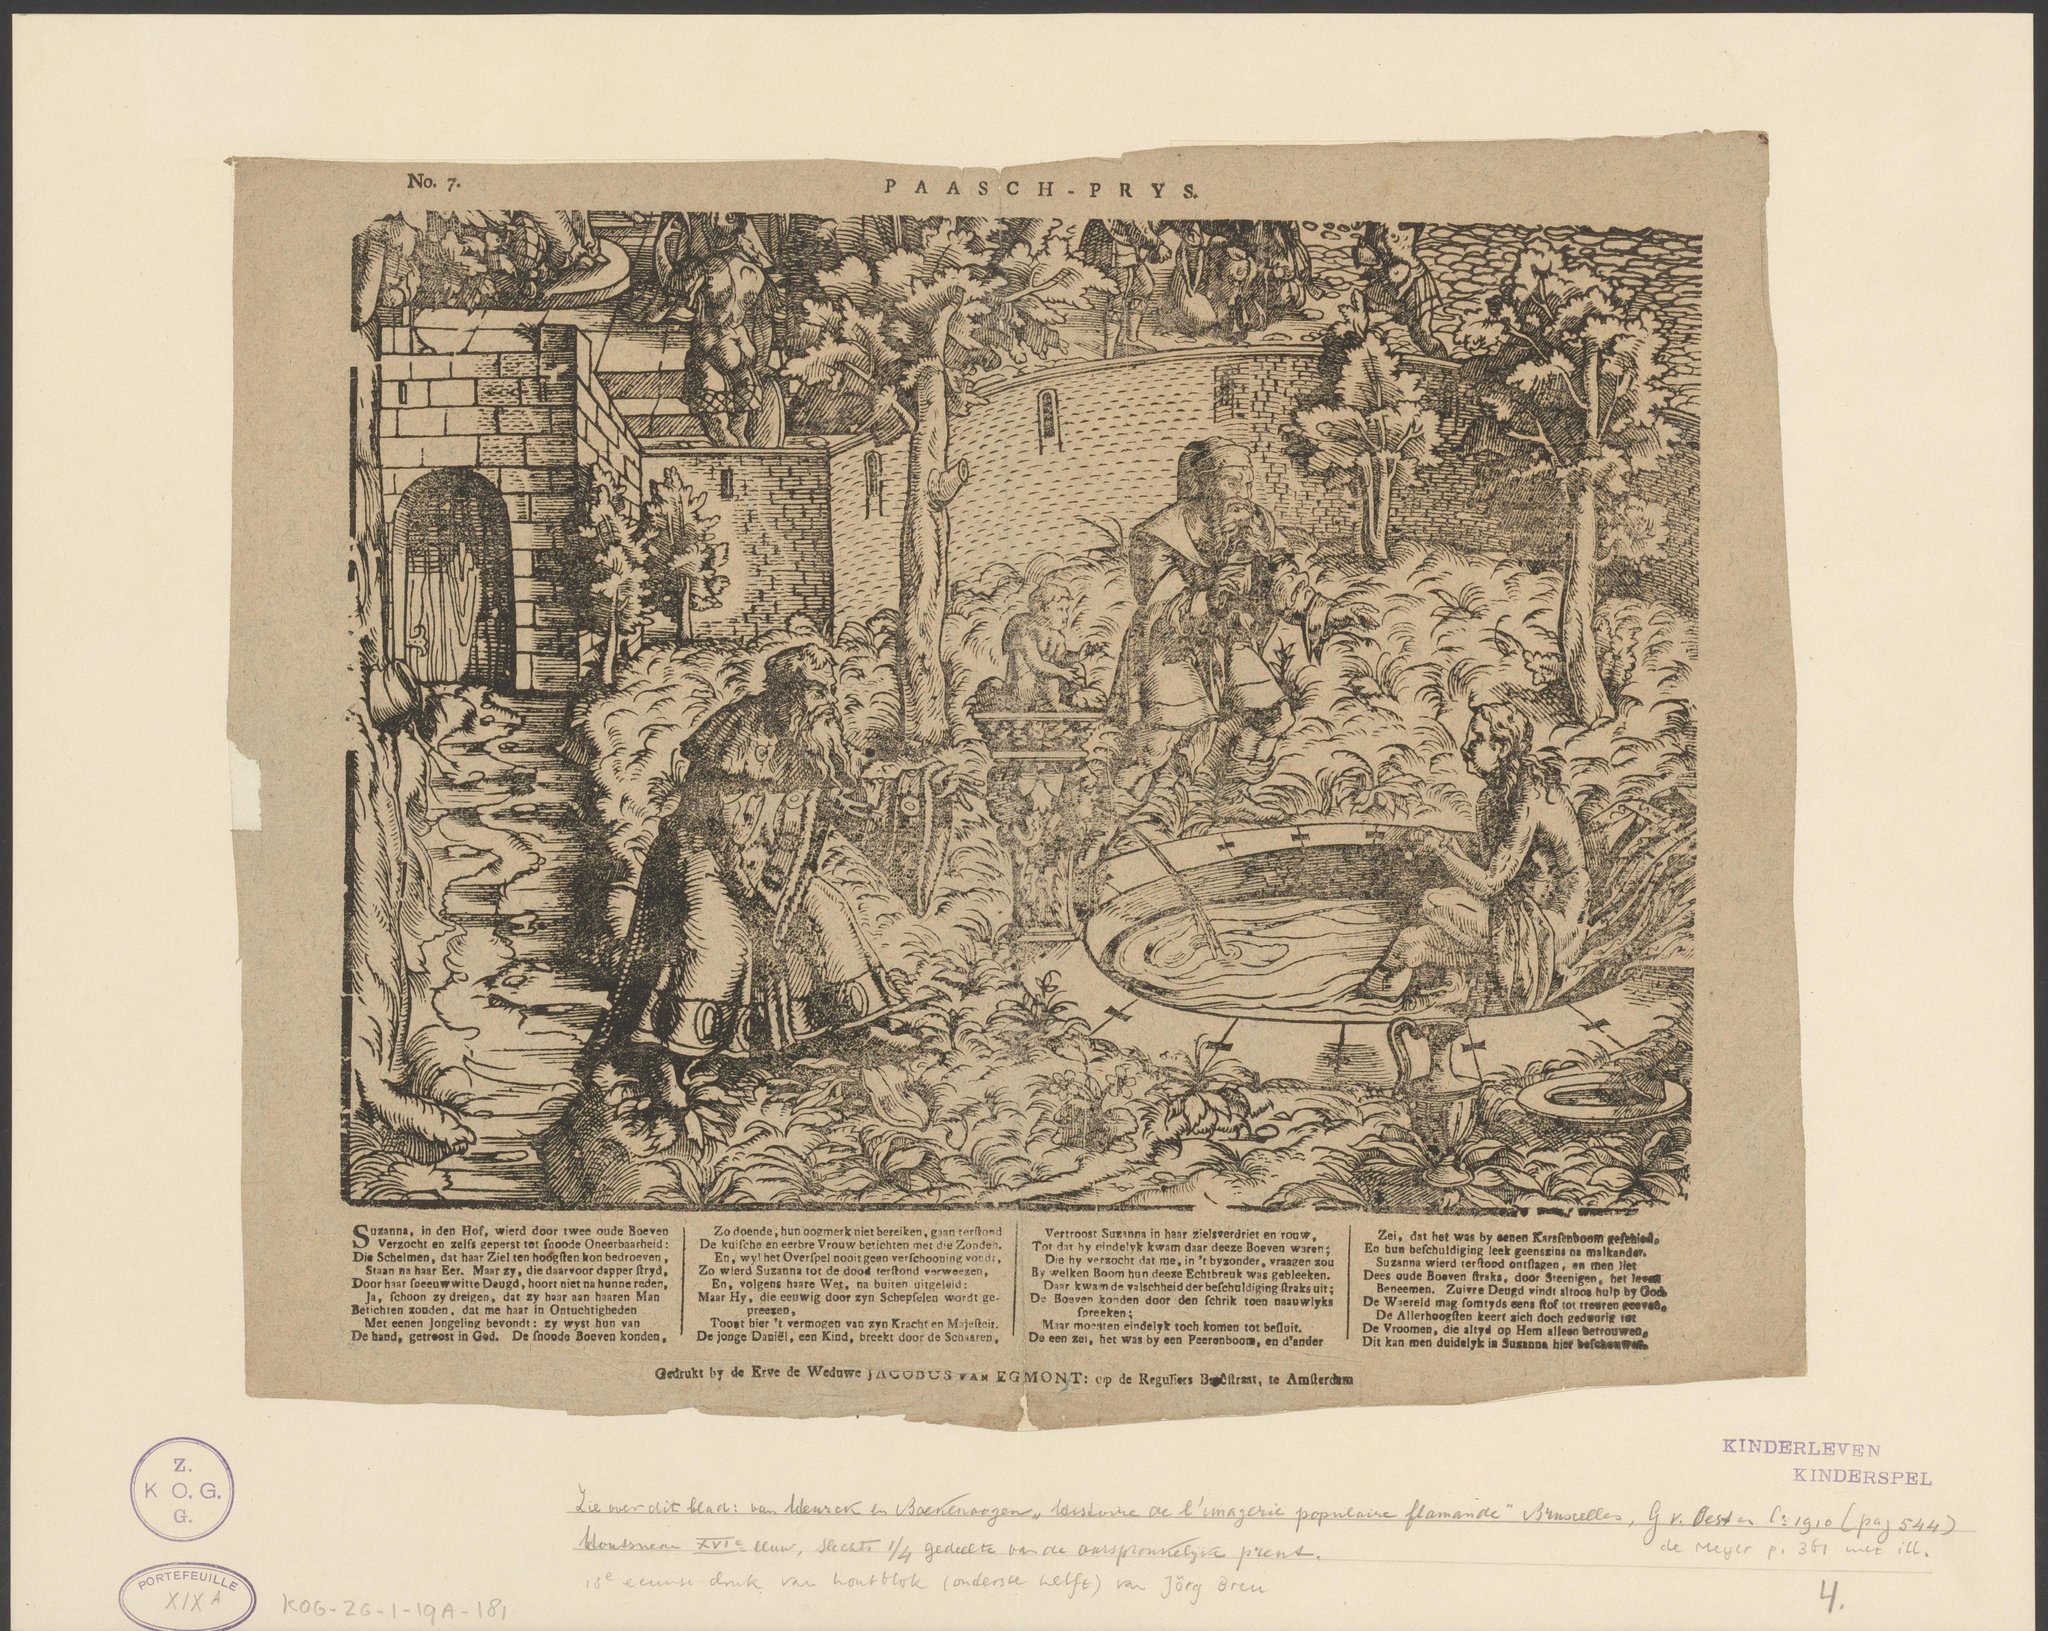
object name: print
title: Susanna en de ouderlingen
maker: Anonymous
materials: paper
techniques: letterpress printing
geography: amsterdam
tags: the elders making advances towards susanna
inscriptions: collector's mark: Lugt 1641, stamp, stamp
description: Onderaan een tekst in vier kolommen. Linksonder genummerd: No. 7. Onderwerpsrubrieken binnen de Atlas Zeden en Gewoonten: Zeden en Gewoonten in Engeren Zin, Des menschen beging, midden en einde, Kinderleven – Kinderspel en Kinderprenten.